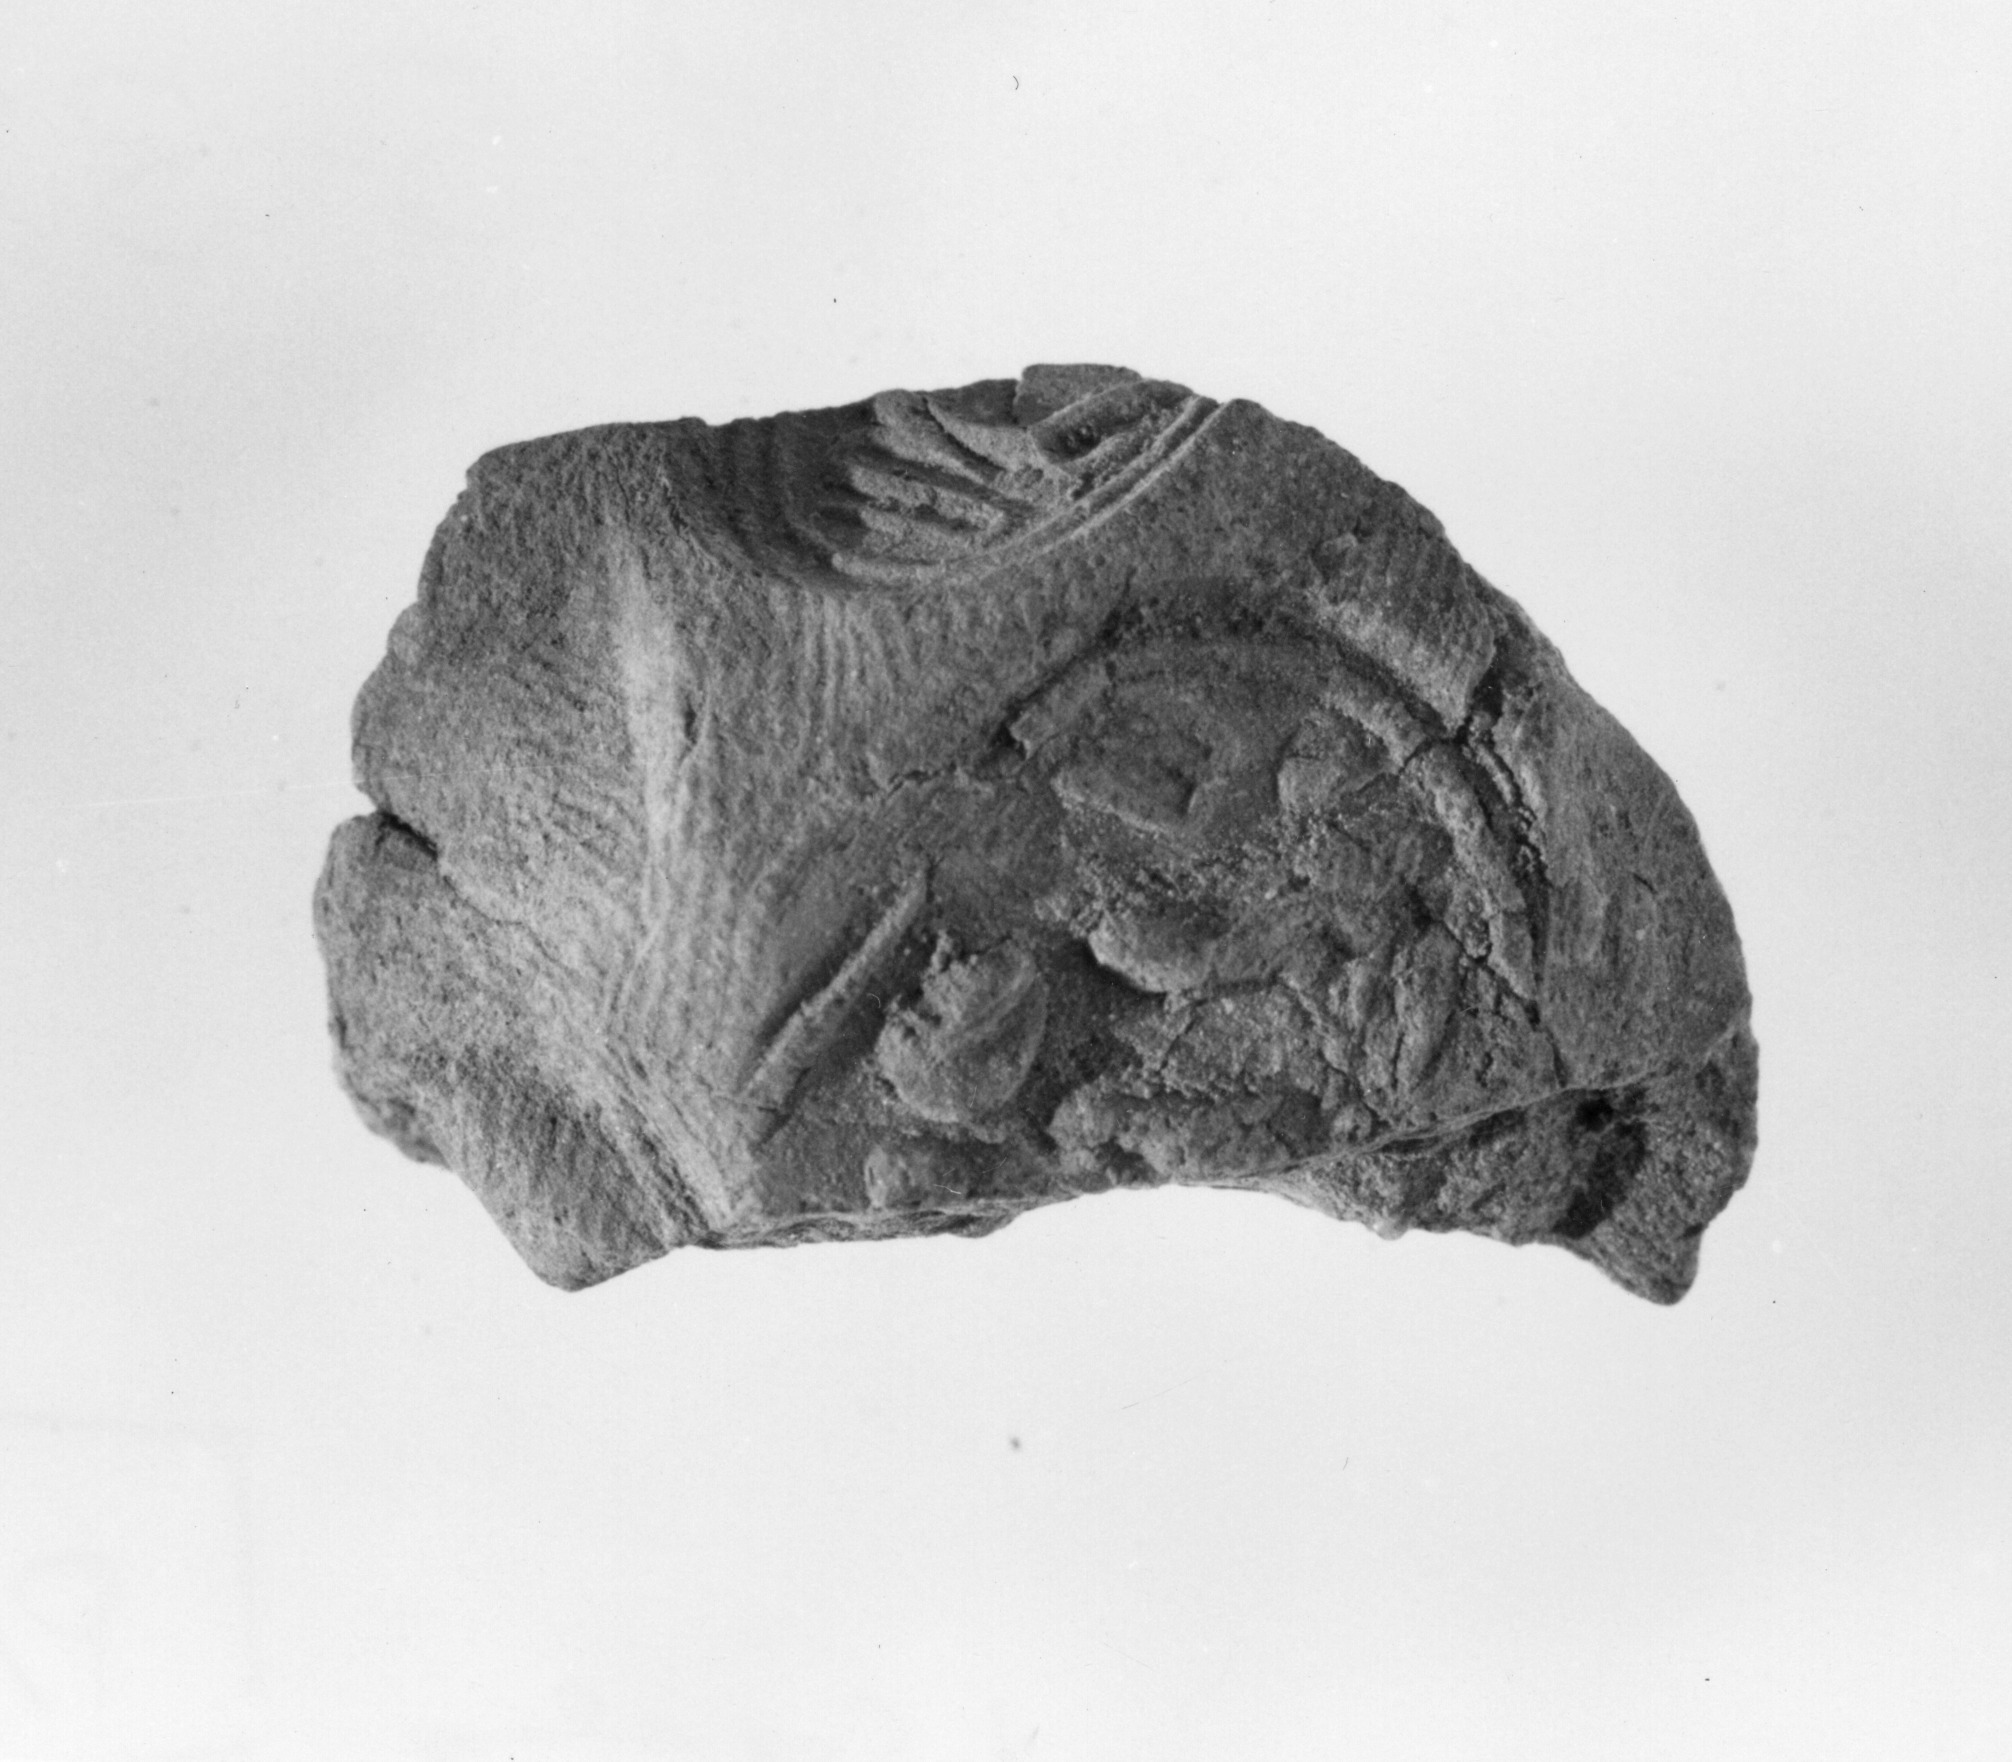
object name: sealing, amenhotep iii, nebmaatre, cobra,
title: Document Sealing With Multiple Seal Impressions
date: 1390-1352 BCE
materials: mud